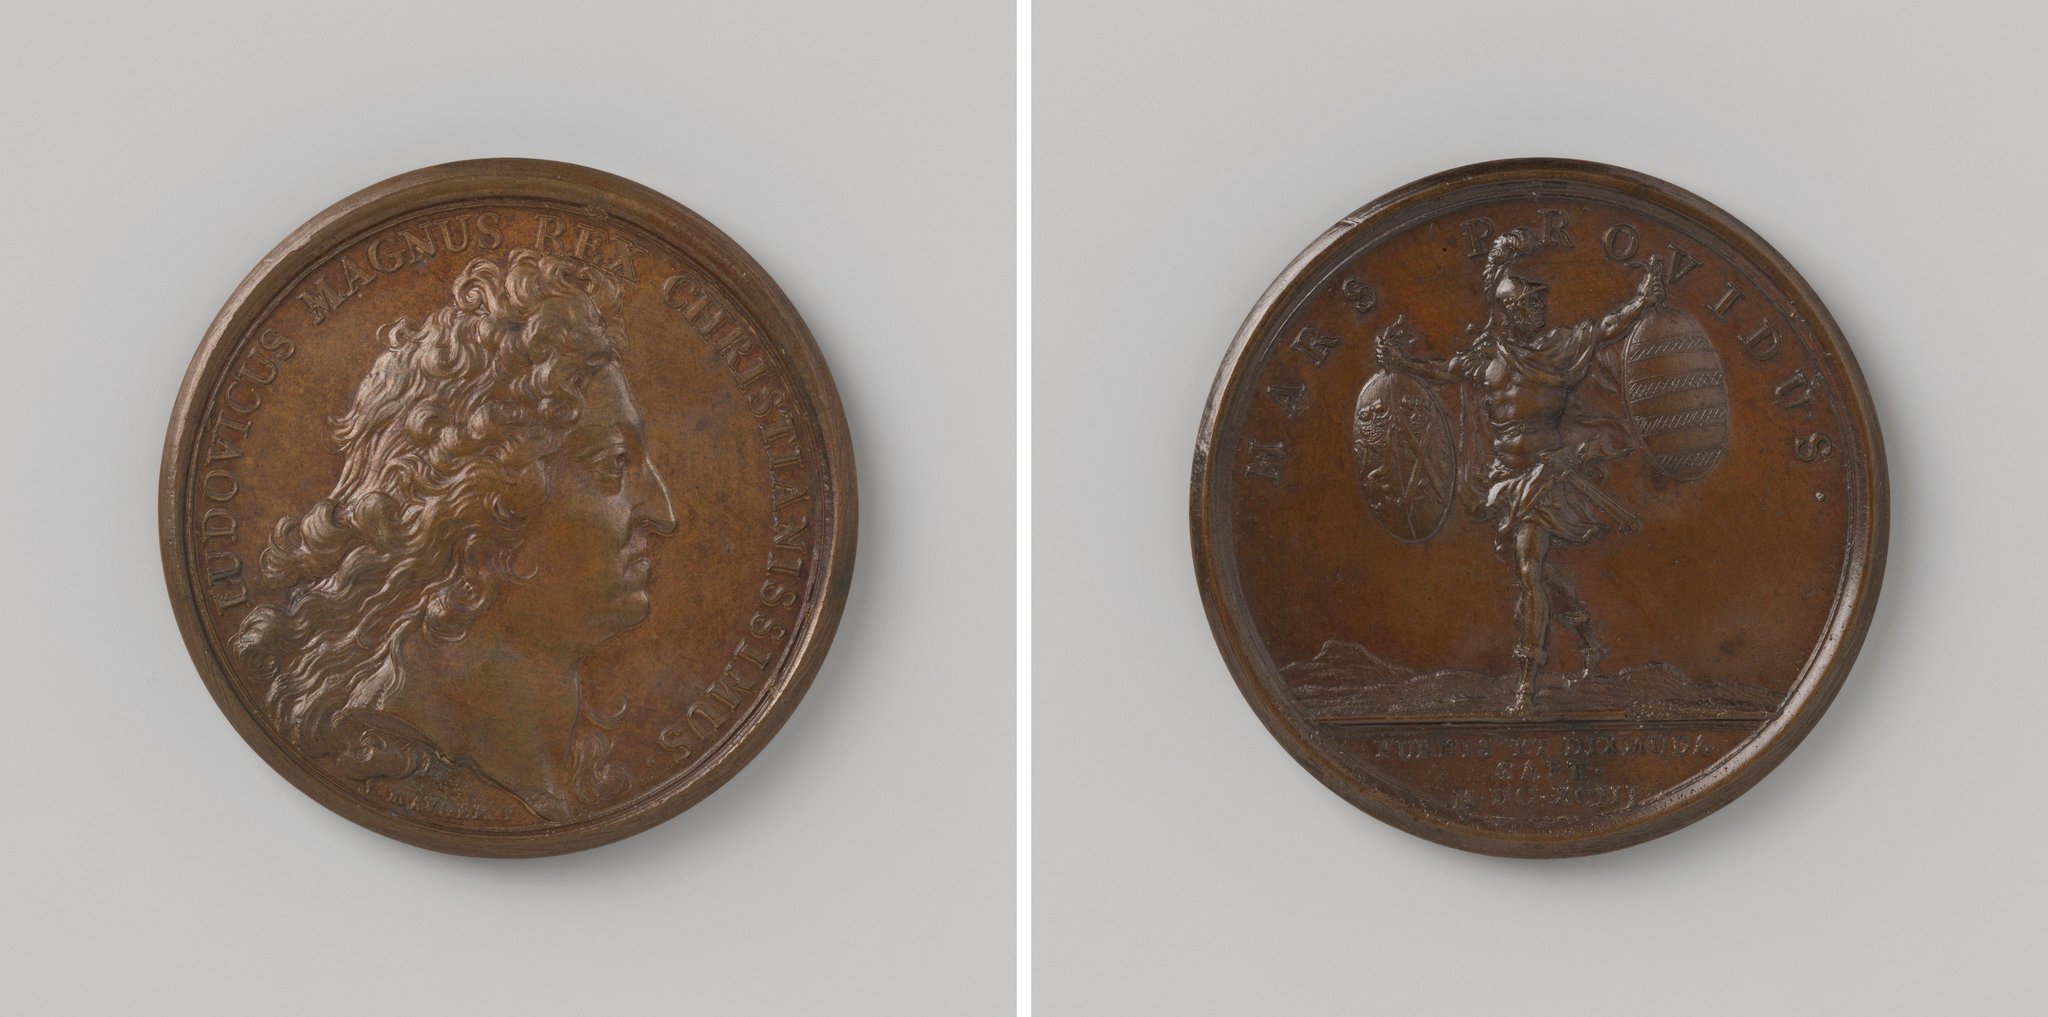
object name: history medal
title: Inname van Veurne en Diksmuide door de Fransen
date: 1693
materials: bronze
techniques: striking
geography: paris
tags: lodewijk xiv (koning van frankrijk)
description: Bronzen penning. Voorzijde: borststuk man binnen omschrift. Keerzijde: Mars met wapenschild van Veurne in rechter- en van Diksmuide in linkerhand binnen omschrift; afsnede: opschrift